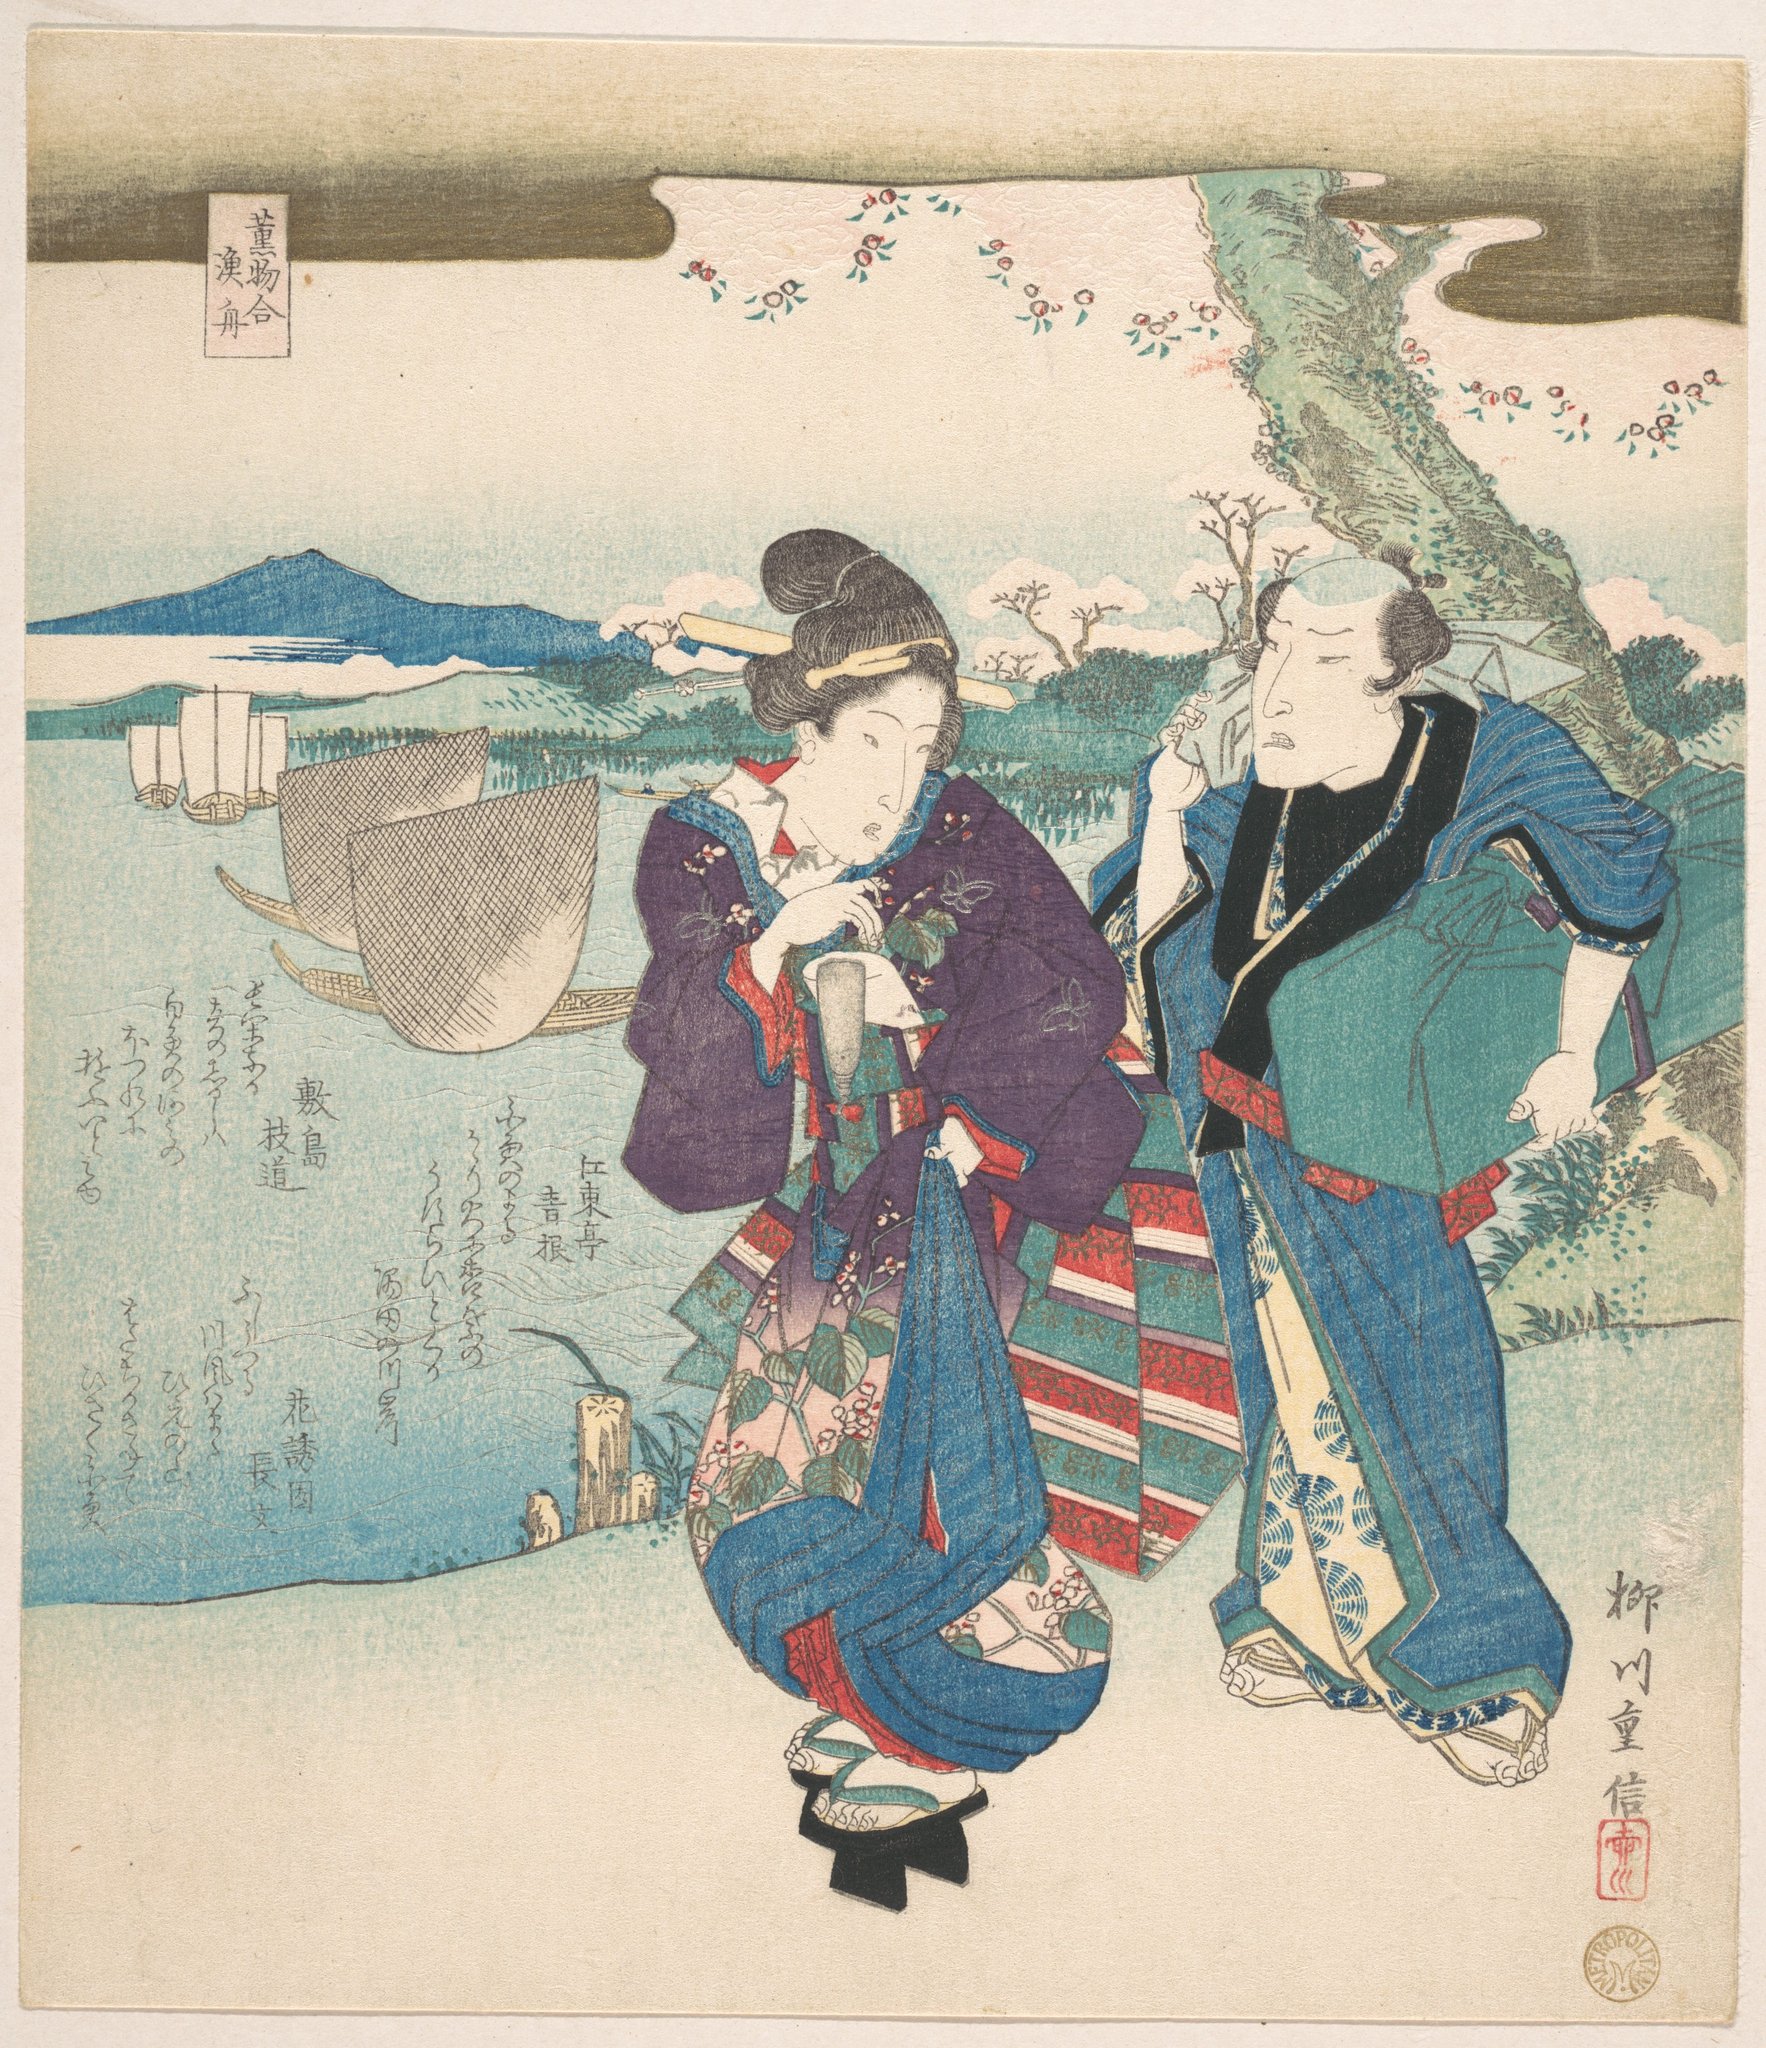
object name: print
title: Kaori-mono-awase, Gyoshu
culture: japanese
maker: yanagawa shigenobu ii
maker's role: artist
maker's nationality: japanese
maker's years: 1820-1859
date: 1830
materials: ink, paper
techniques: surimono, woodblock print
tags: men,women,hills,boats